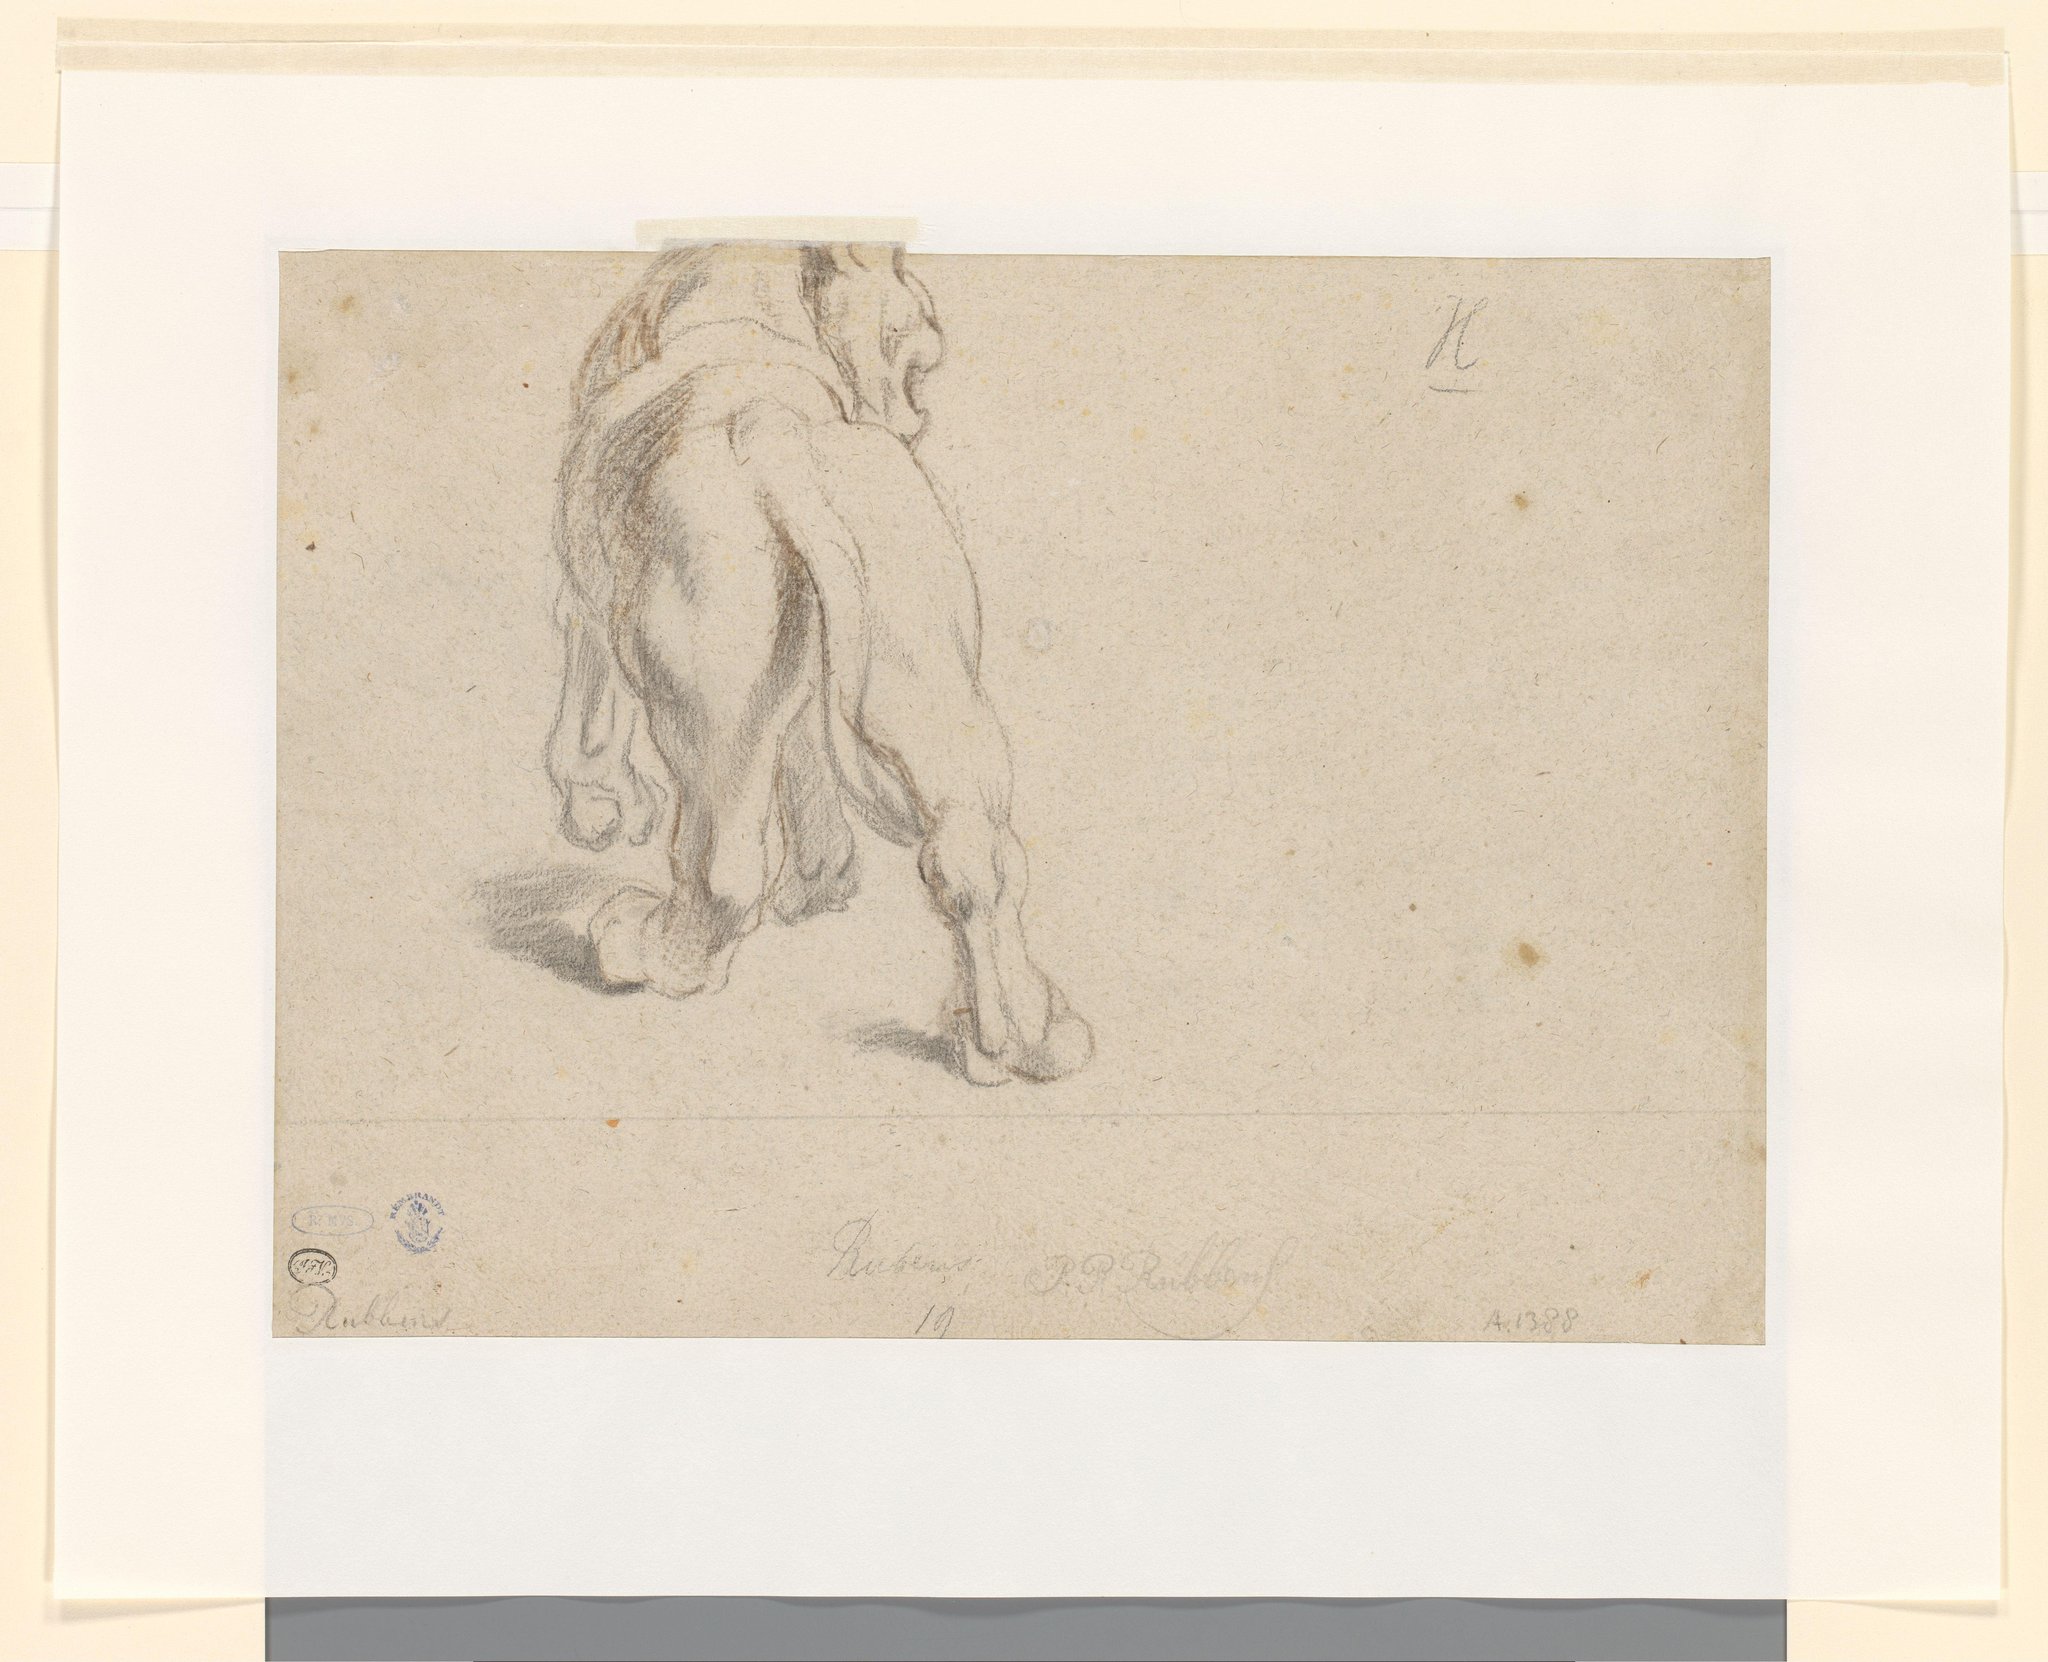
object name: drawing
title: Leeuw, van achteren gezien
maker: peter paul rubens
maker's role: draughtsman, painter, print maker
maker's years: 1577-1640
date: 1587-1640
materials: chalk, paper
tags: beasts of prey, predatory animals: lion